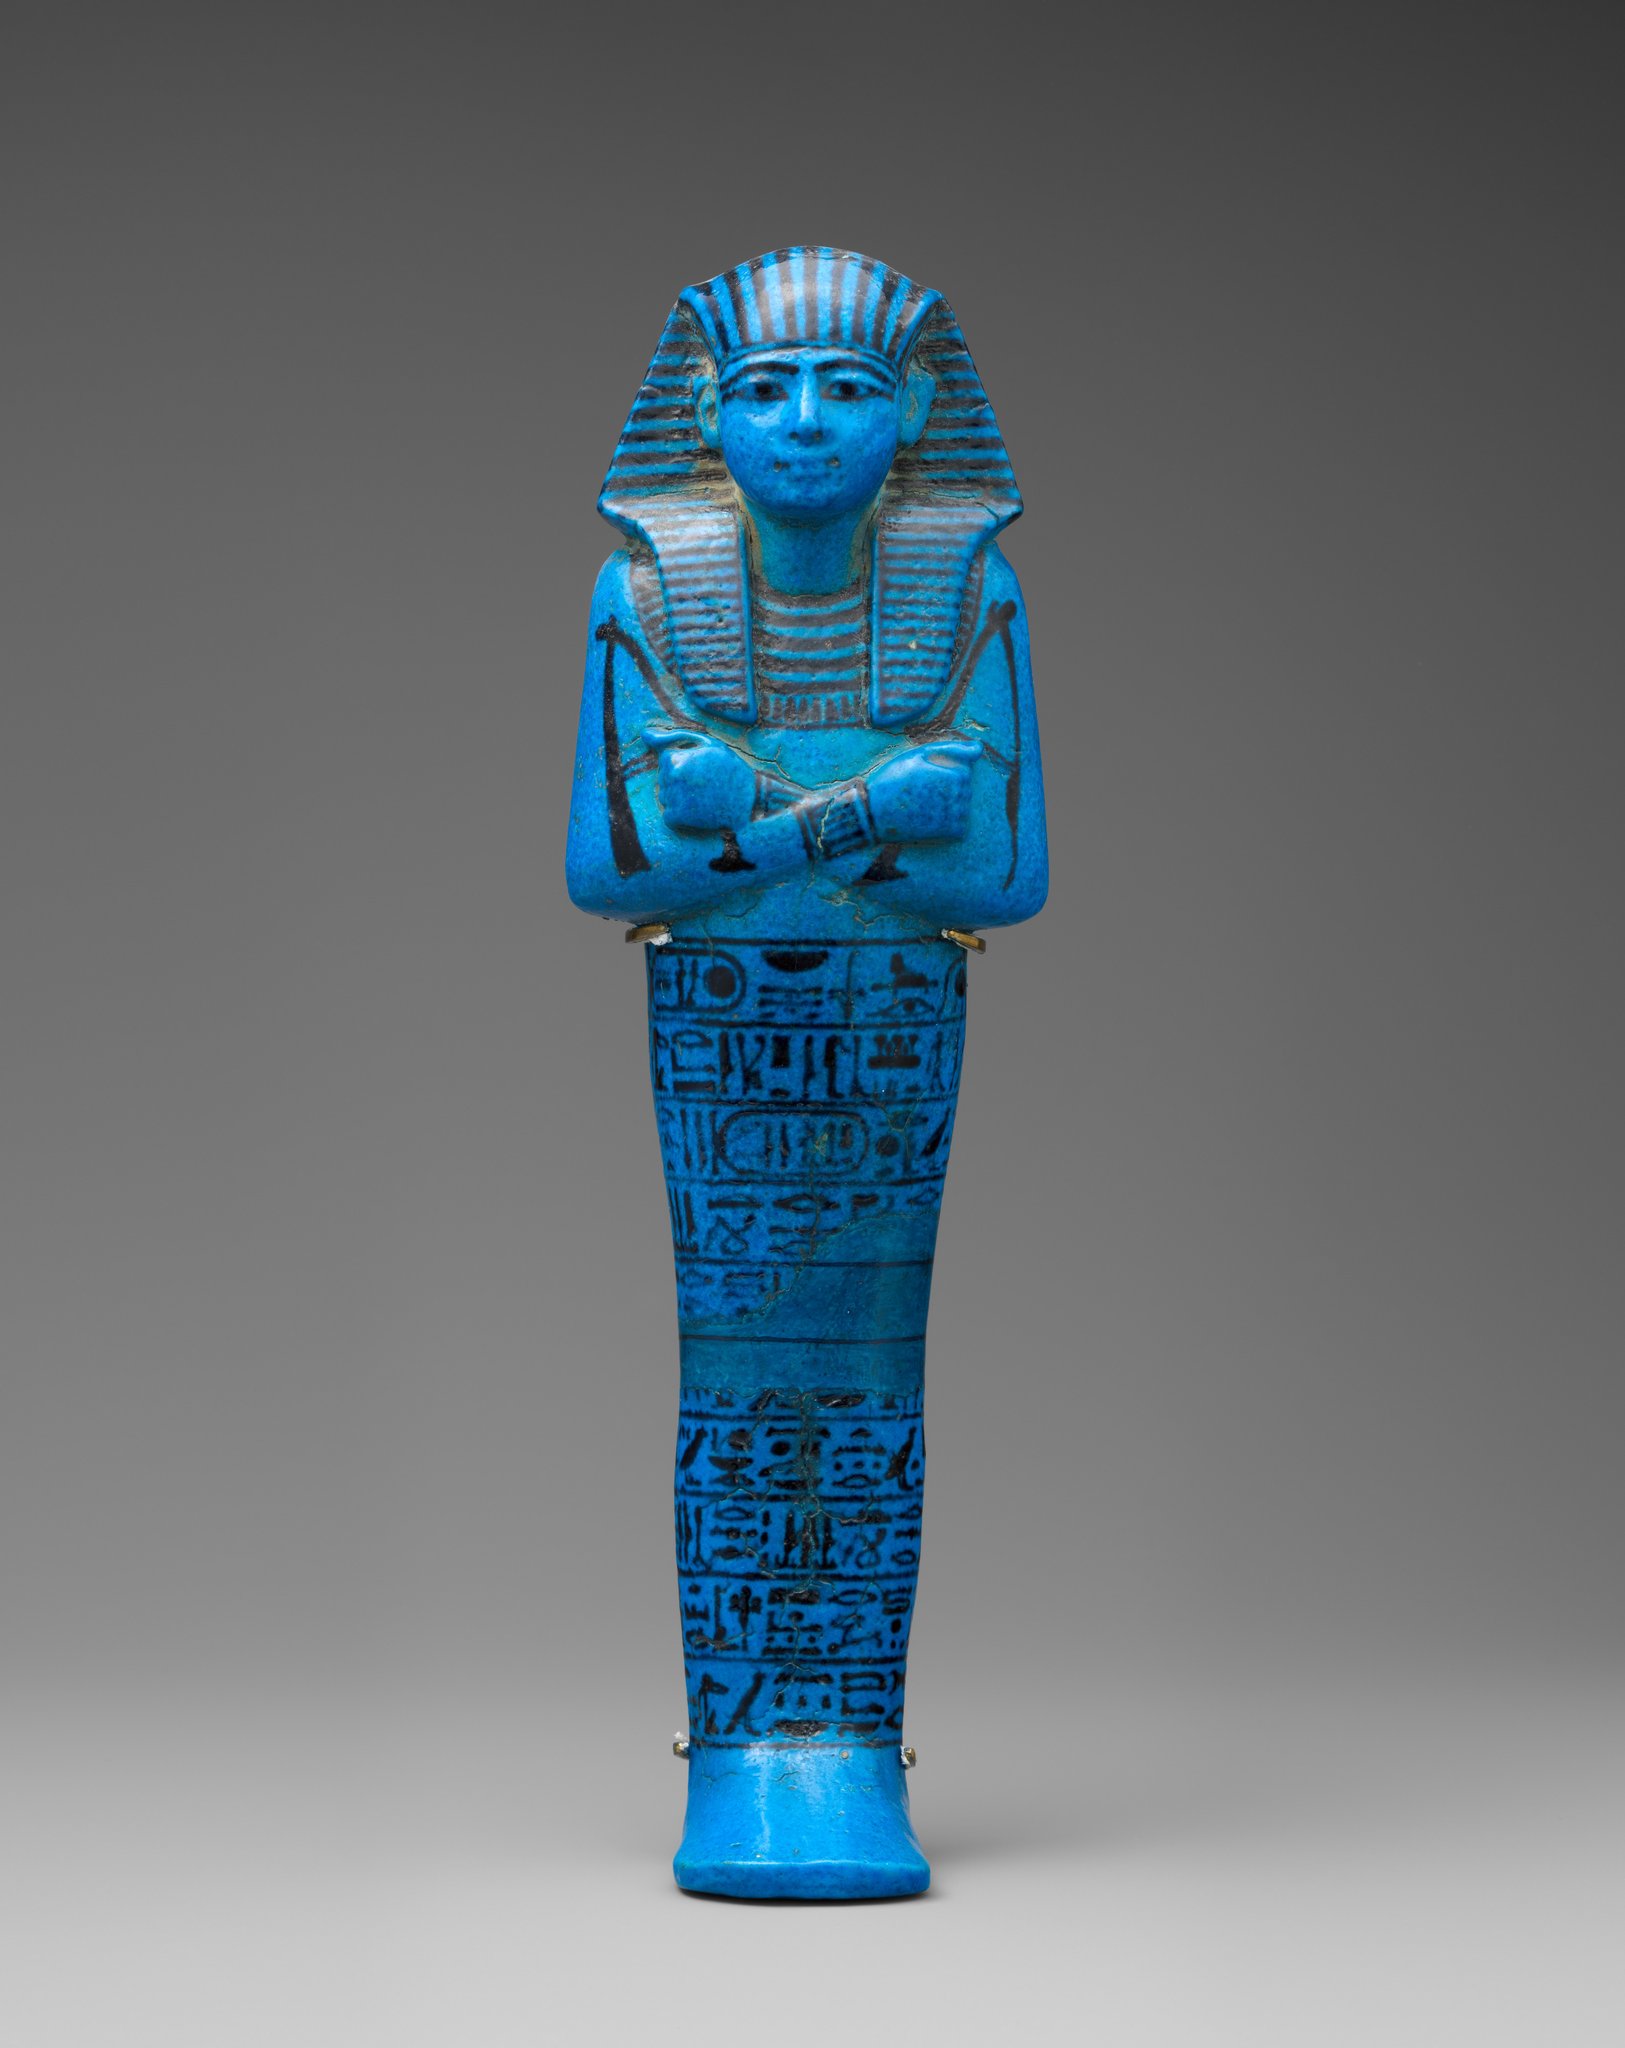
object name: shabti, seti i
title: Shabti of Seti I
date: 1294-1279 BCE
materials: faience, paint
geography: egypt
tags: hieroglyphs